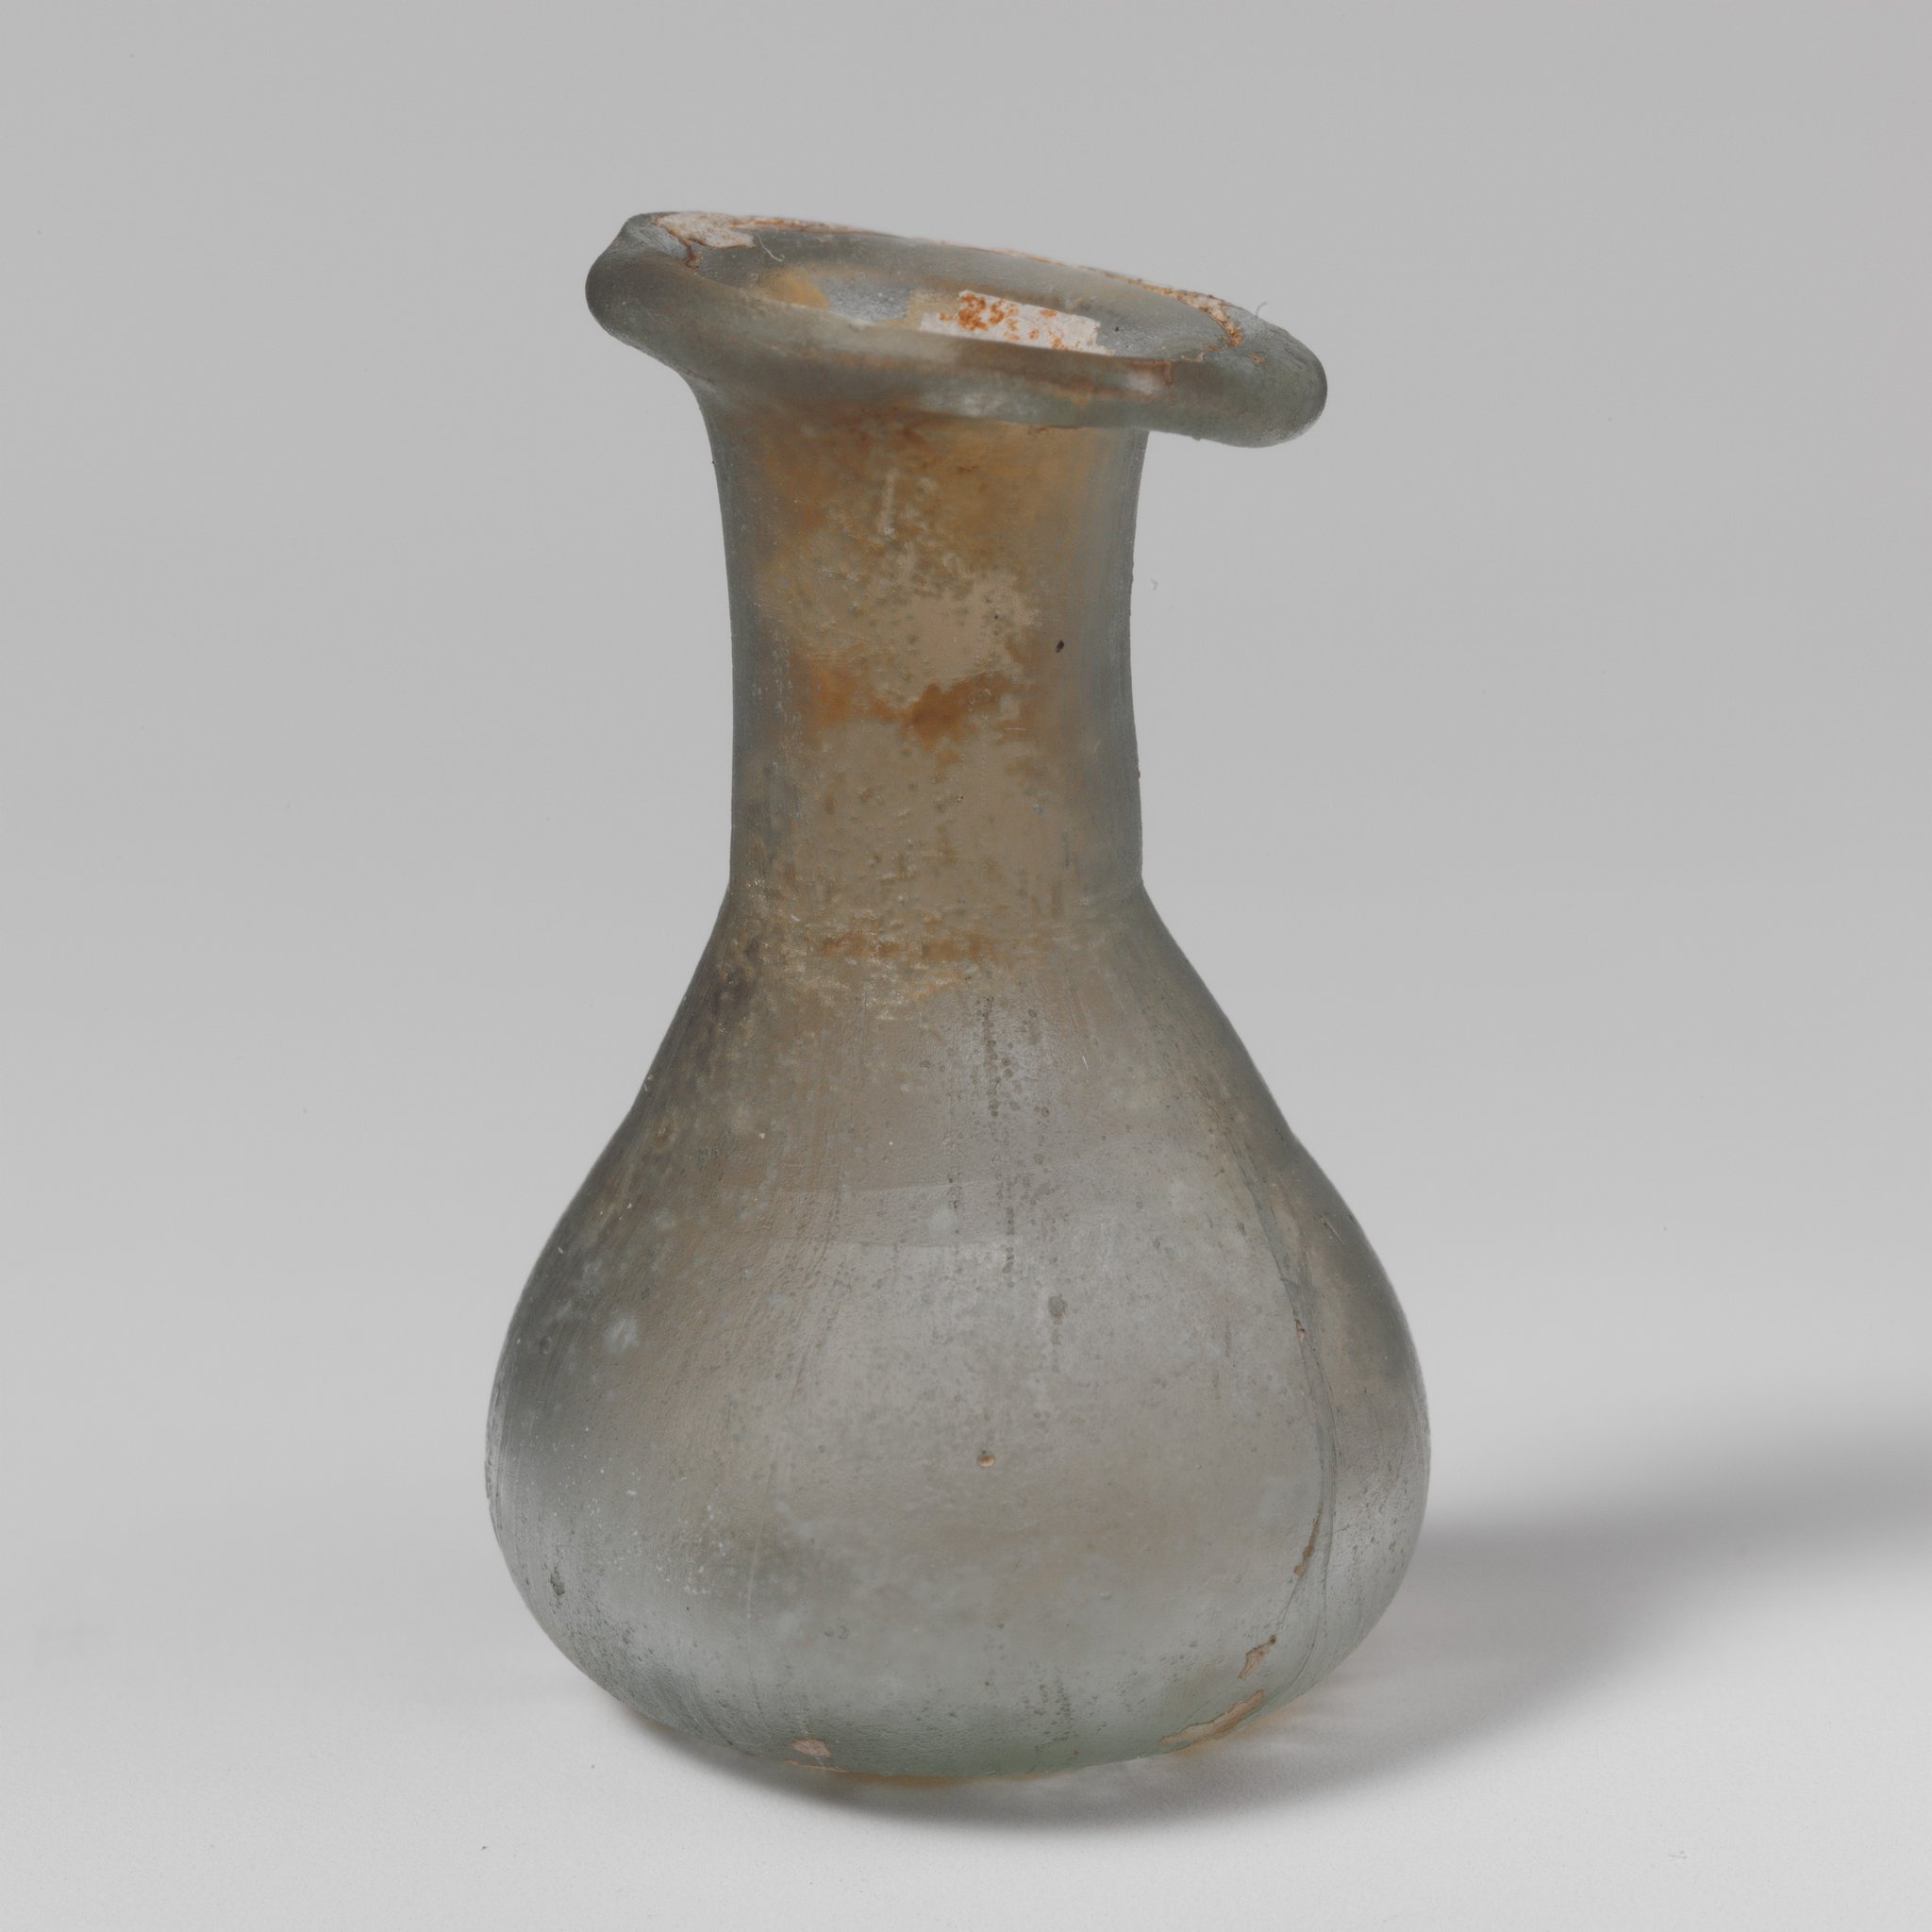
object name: perfume bottle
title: Glass perfume bottle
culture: roman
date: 1-200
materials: glass